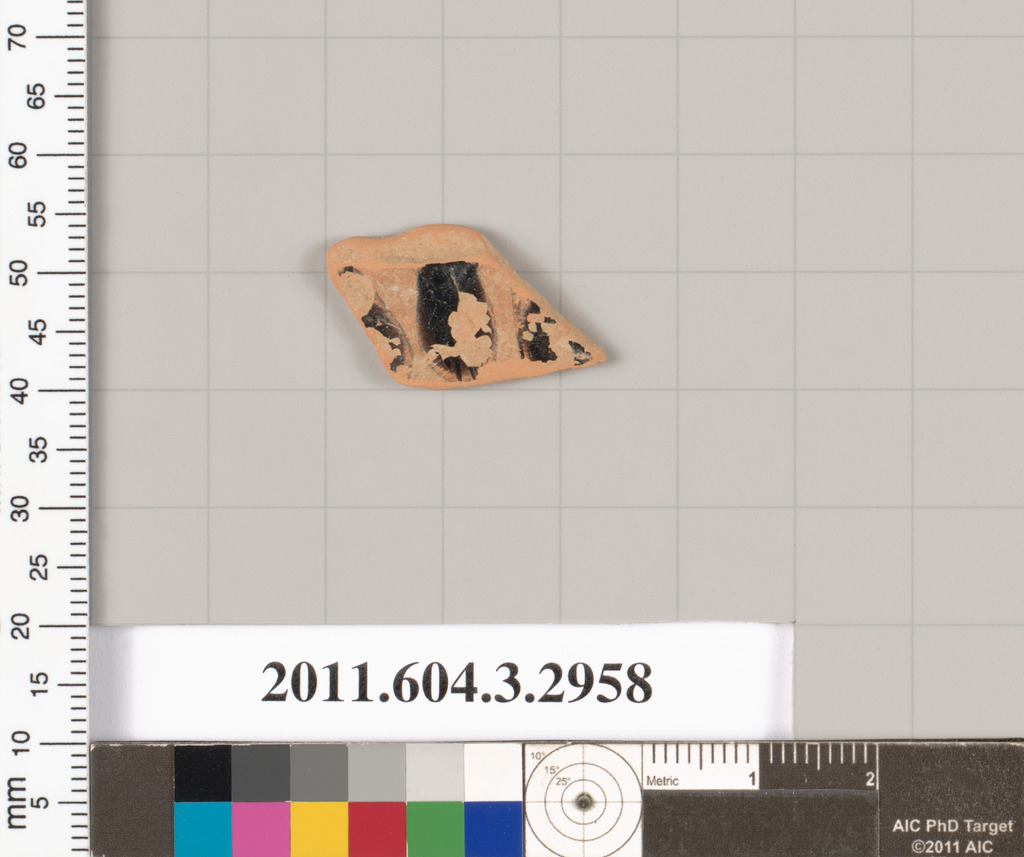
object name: lekythos fragment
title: Terracotta fragment of a lekythos (oil flask)?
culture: greek, attic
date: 534-468 BCE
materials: terracotta